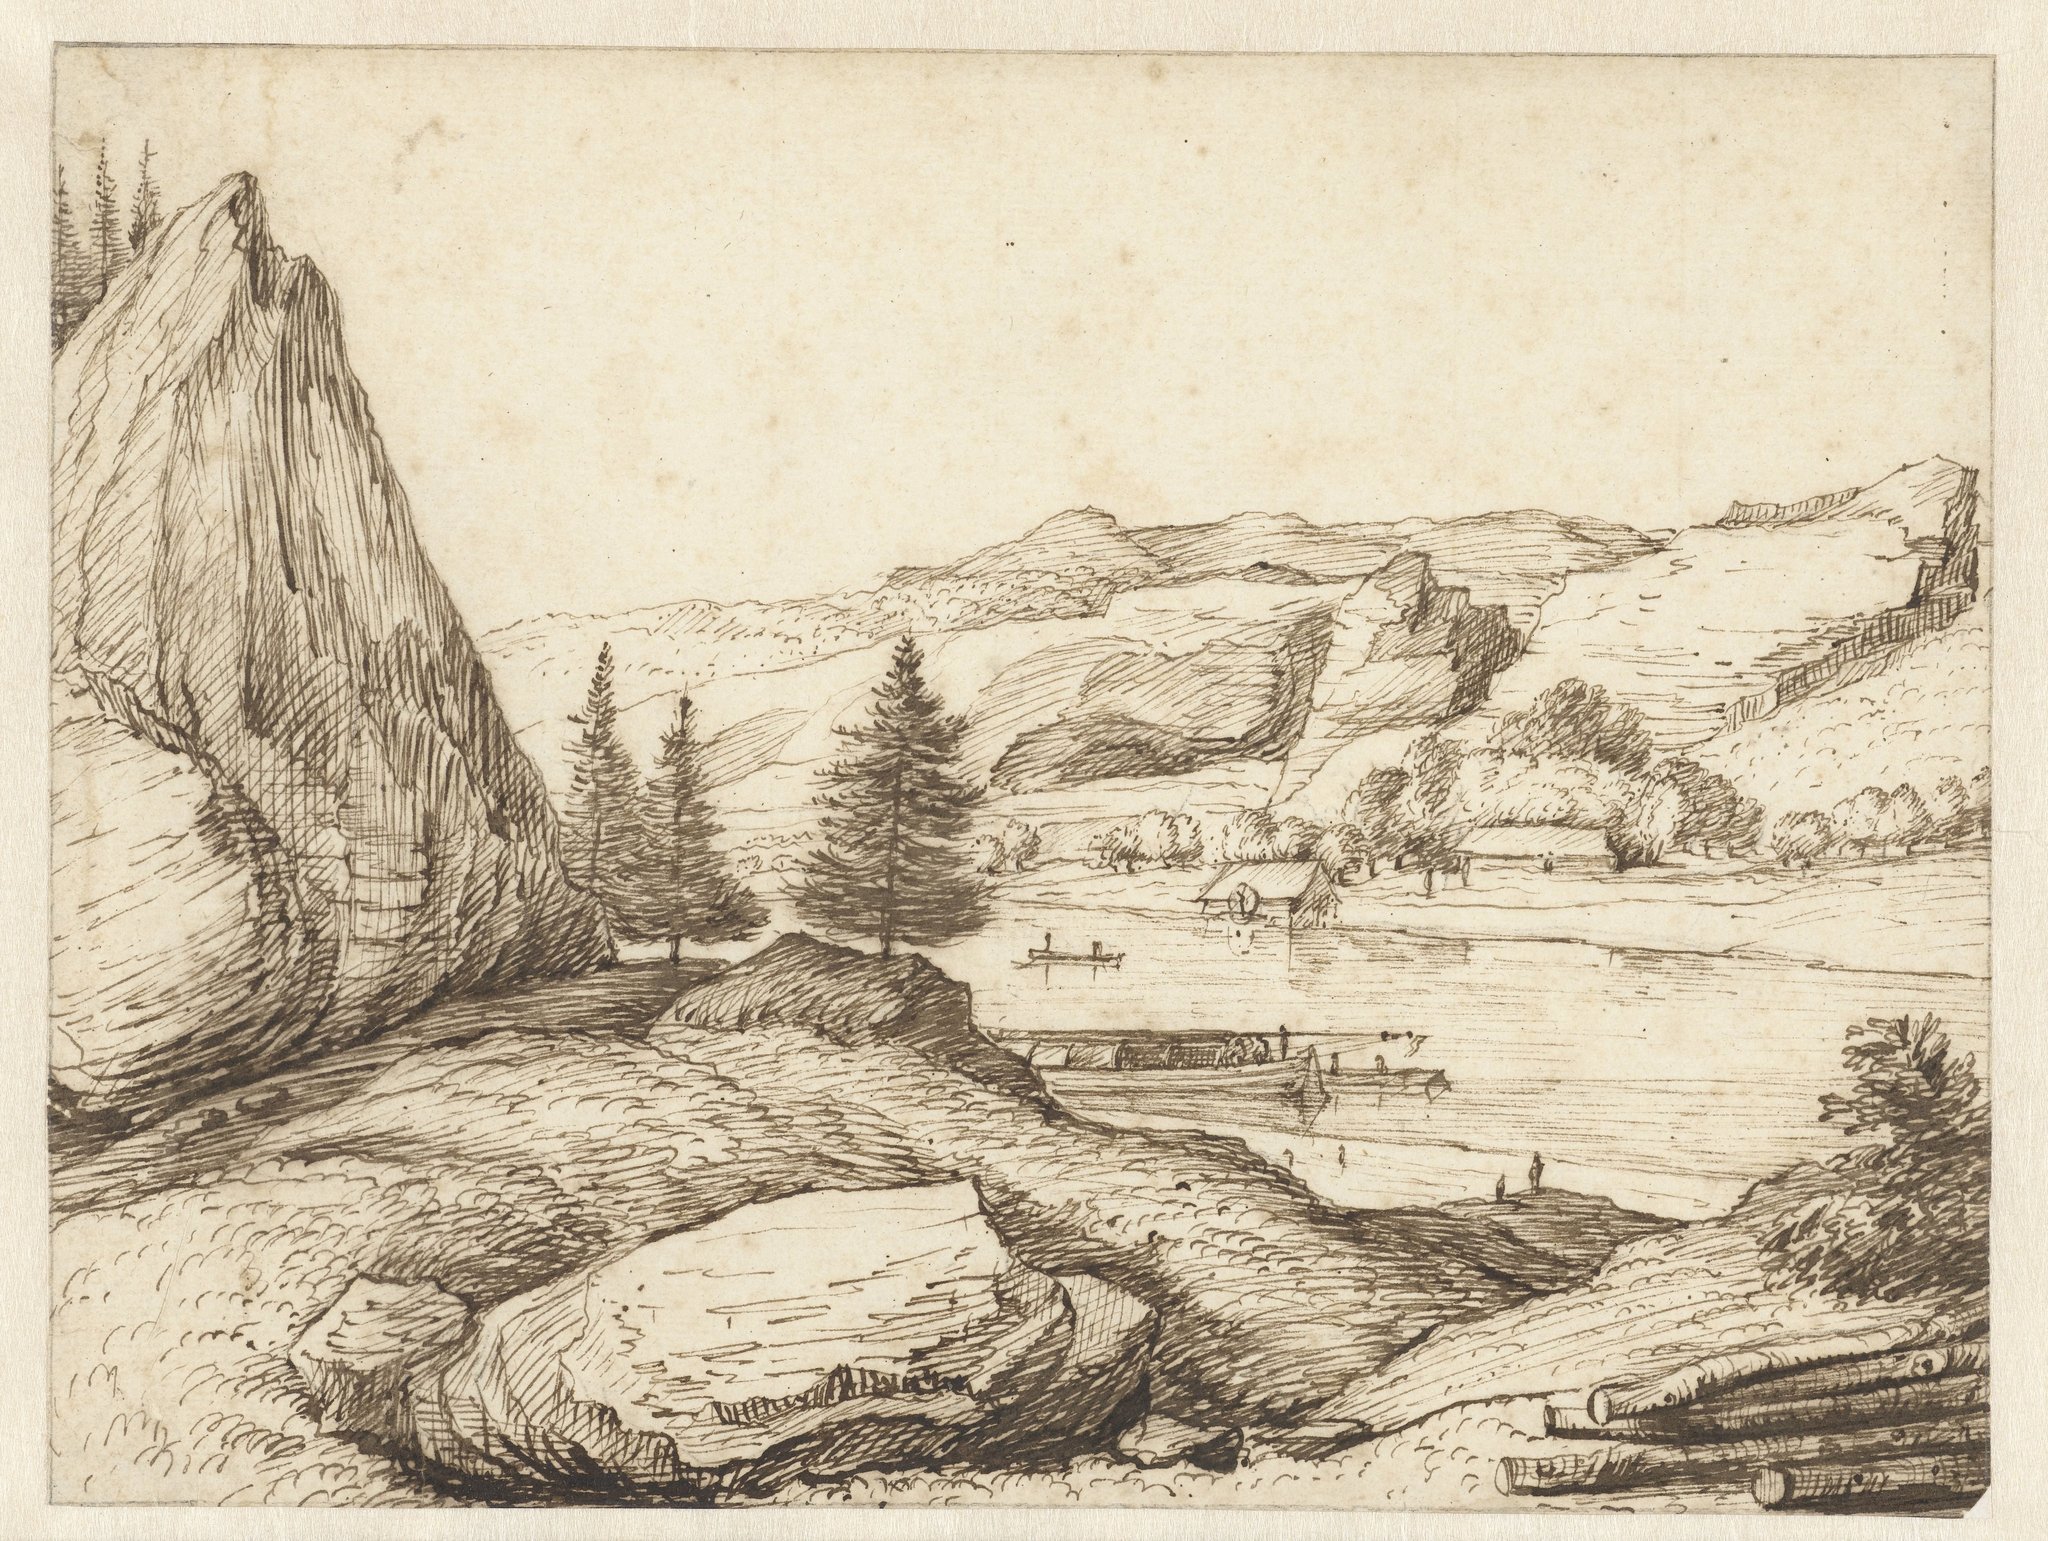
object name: drawing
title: Berglandschap met een rivier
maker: jacob esselens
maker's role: draughtsman, print maker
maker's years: 1626-1687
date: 1636-1687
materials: ink, paper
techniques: pen